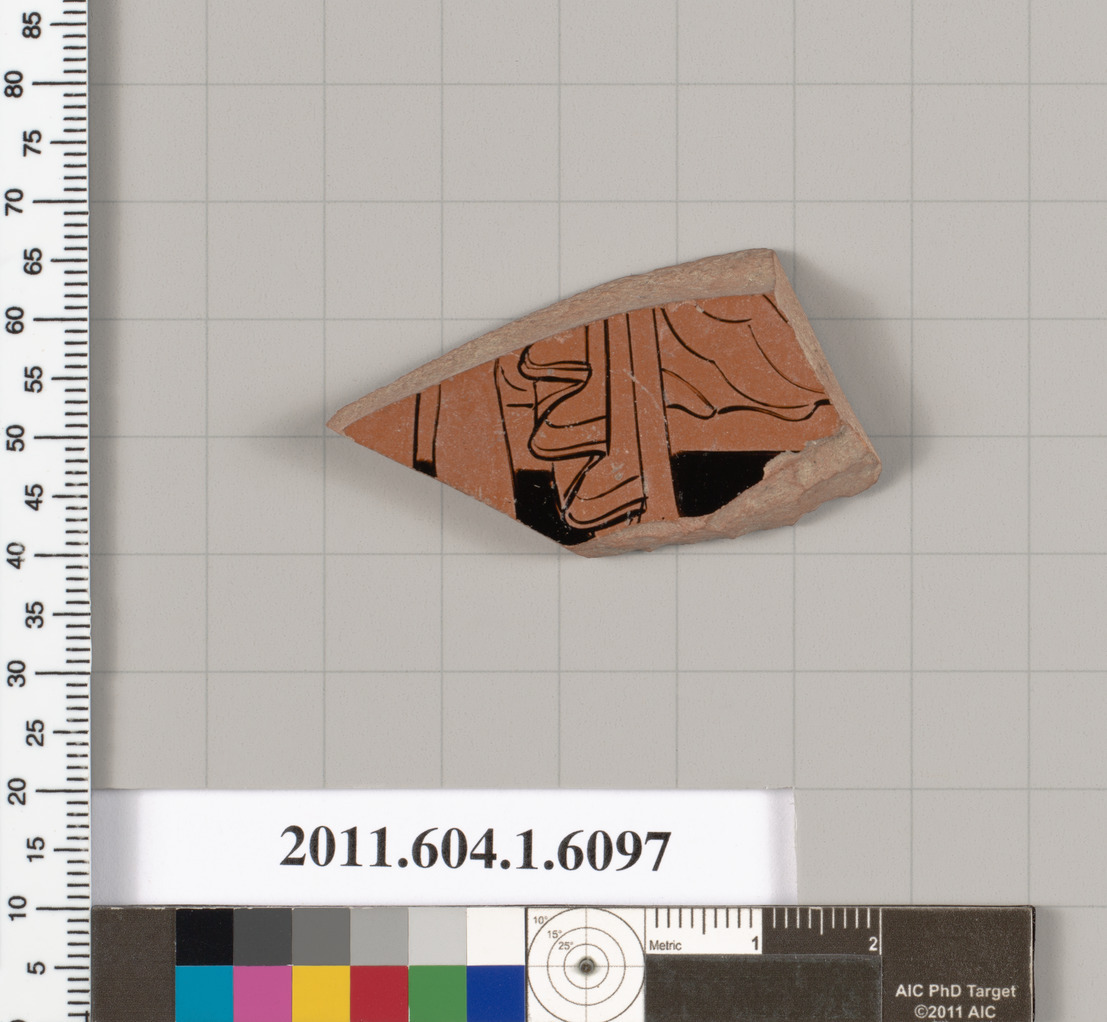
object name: kylix fragment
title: Terracotta fragment of a kylix (drinking cup)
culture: greek, attic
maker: apollodoros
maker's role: artist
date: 500-490 BCE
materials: terracotta